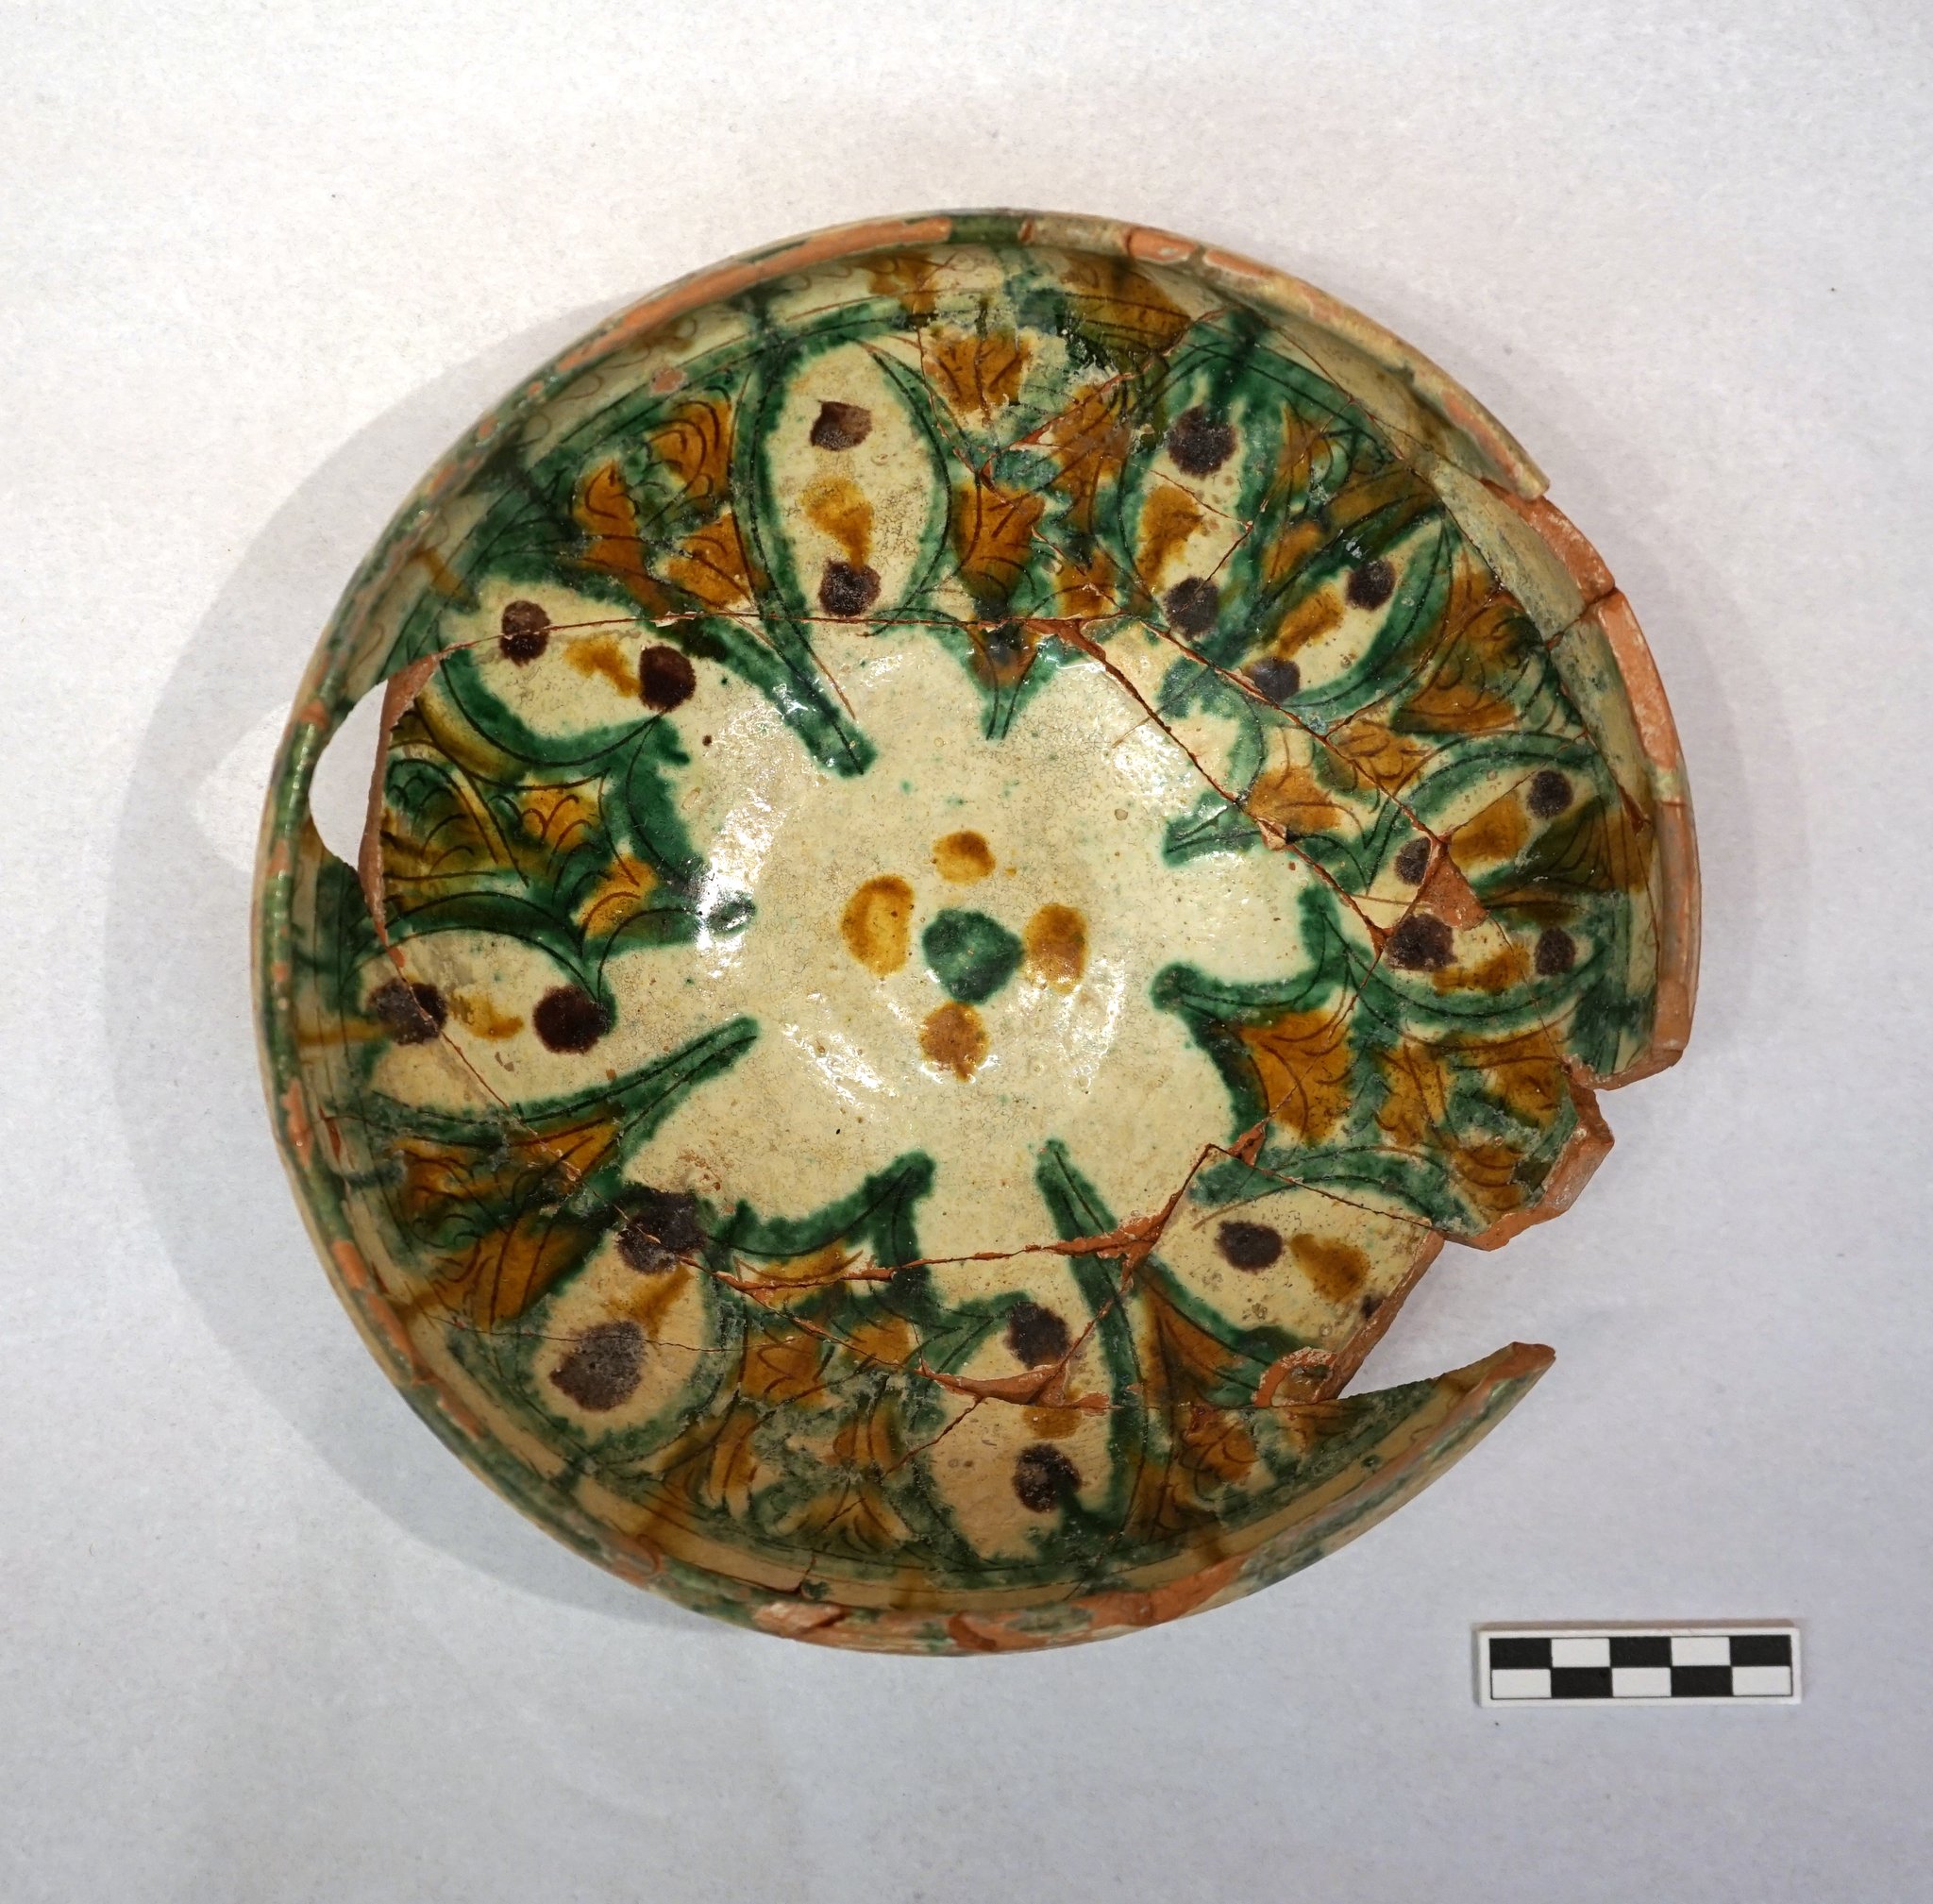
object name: bowl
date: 801-1000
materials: earthenware, glaze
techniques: incising, polychrome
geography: iran